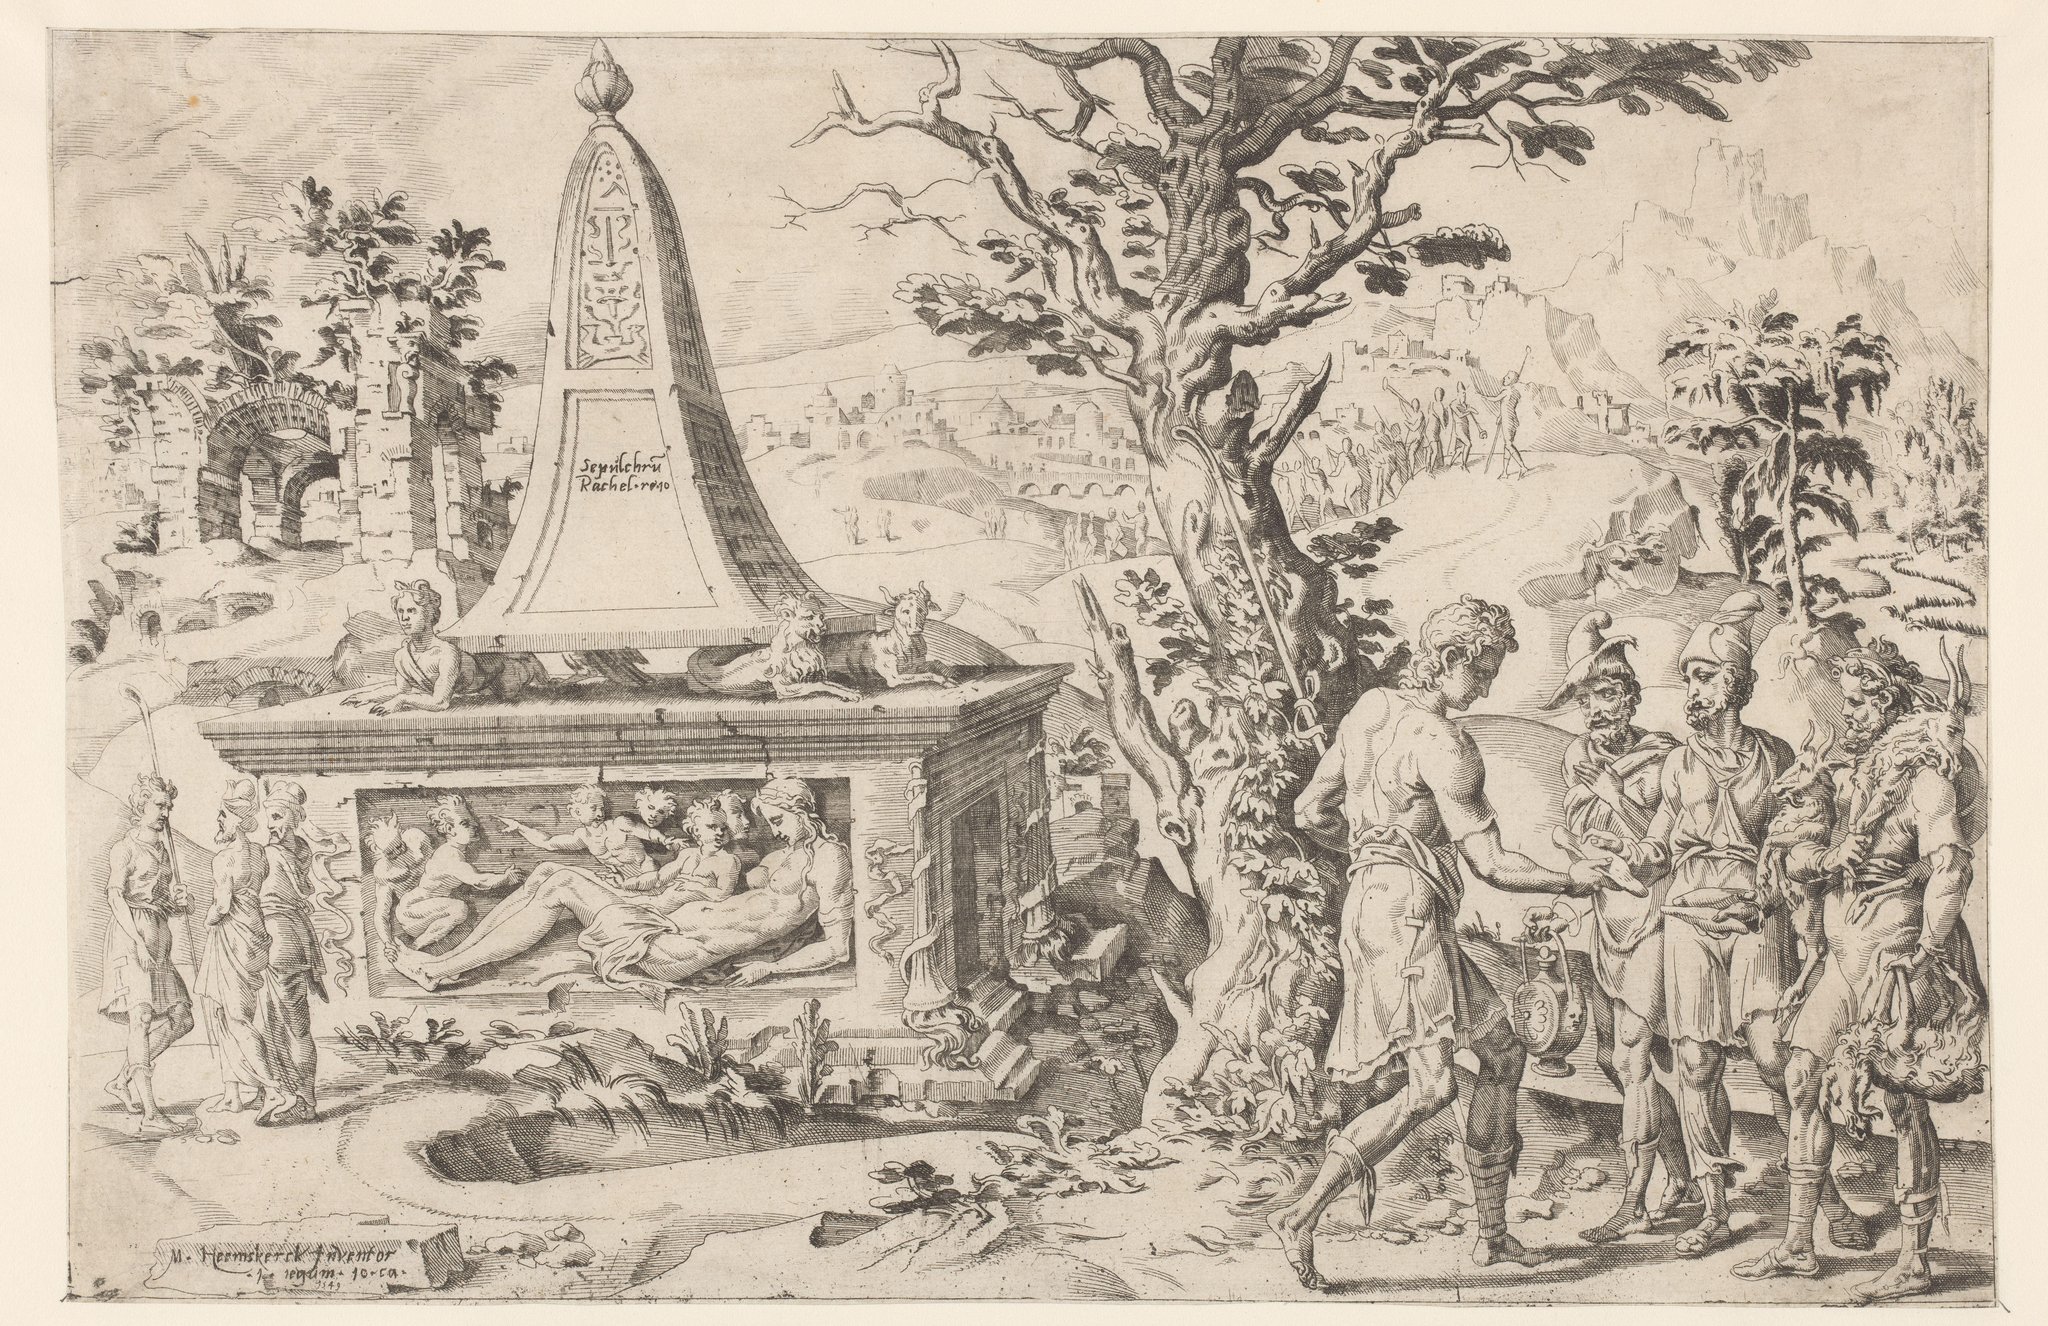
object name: print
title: Saul keert terug naar zijn vader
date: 1549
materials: paper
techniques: etching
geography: haarlem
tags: saul meets a group of prophets playing harps, drums, flutes and lyres, saul meets three men in the plain of thabor, who offer him two loaves of bread, saul meets two men near rachel's grave, who tell him that the asses have been found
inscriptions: collector's mark: Lugt 2228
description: Na de zalving van Samuel keert Saul terug naar zijn vader. Onderweg passeert hij het graf van Rachel. Links in de hoek ontmoet hij daar twee mannen die naar hem op zoek zijn. Vervolgens ontmoet hij rechts op de voorgrond drie mannen: de eerste heeft drie geitenbokken bij zich, de tweede drie broden en de derde een kruik wijn. De mannen geven twee van de broden aan Samuel. Op de achtergrond ontmoet Saul muziek makende profeten. Deze drie ontmoetingen waren voordien door Samuel voorspeld.